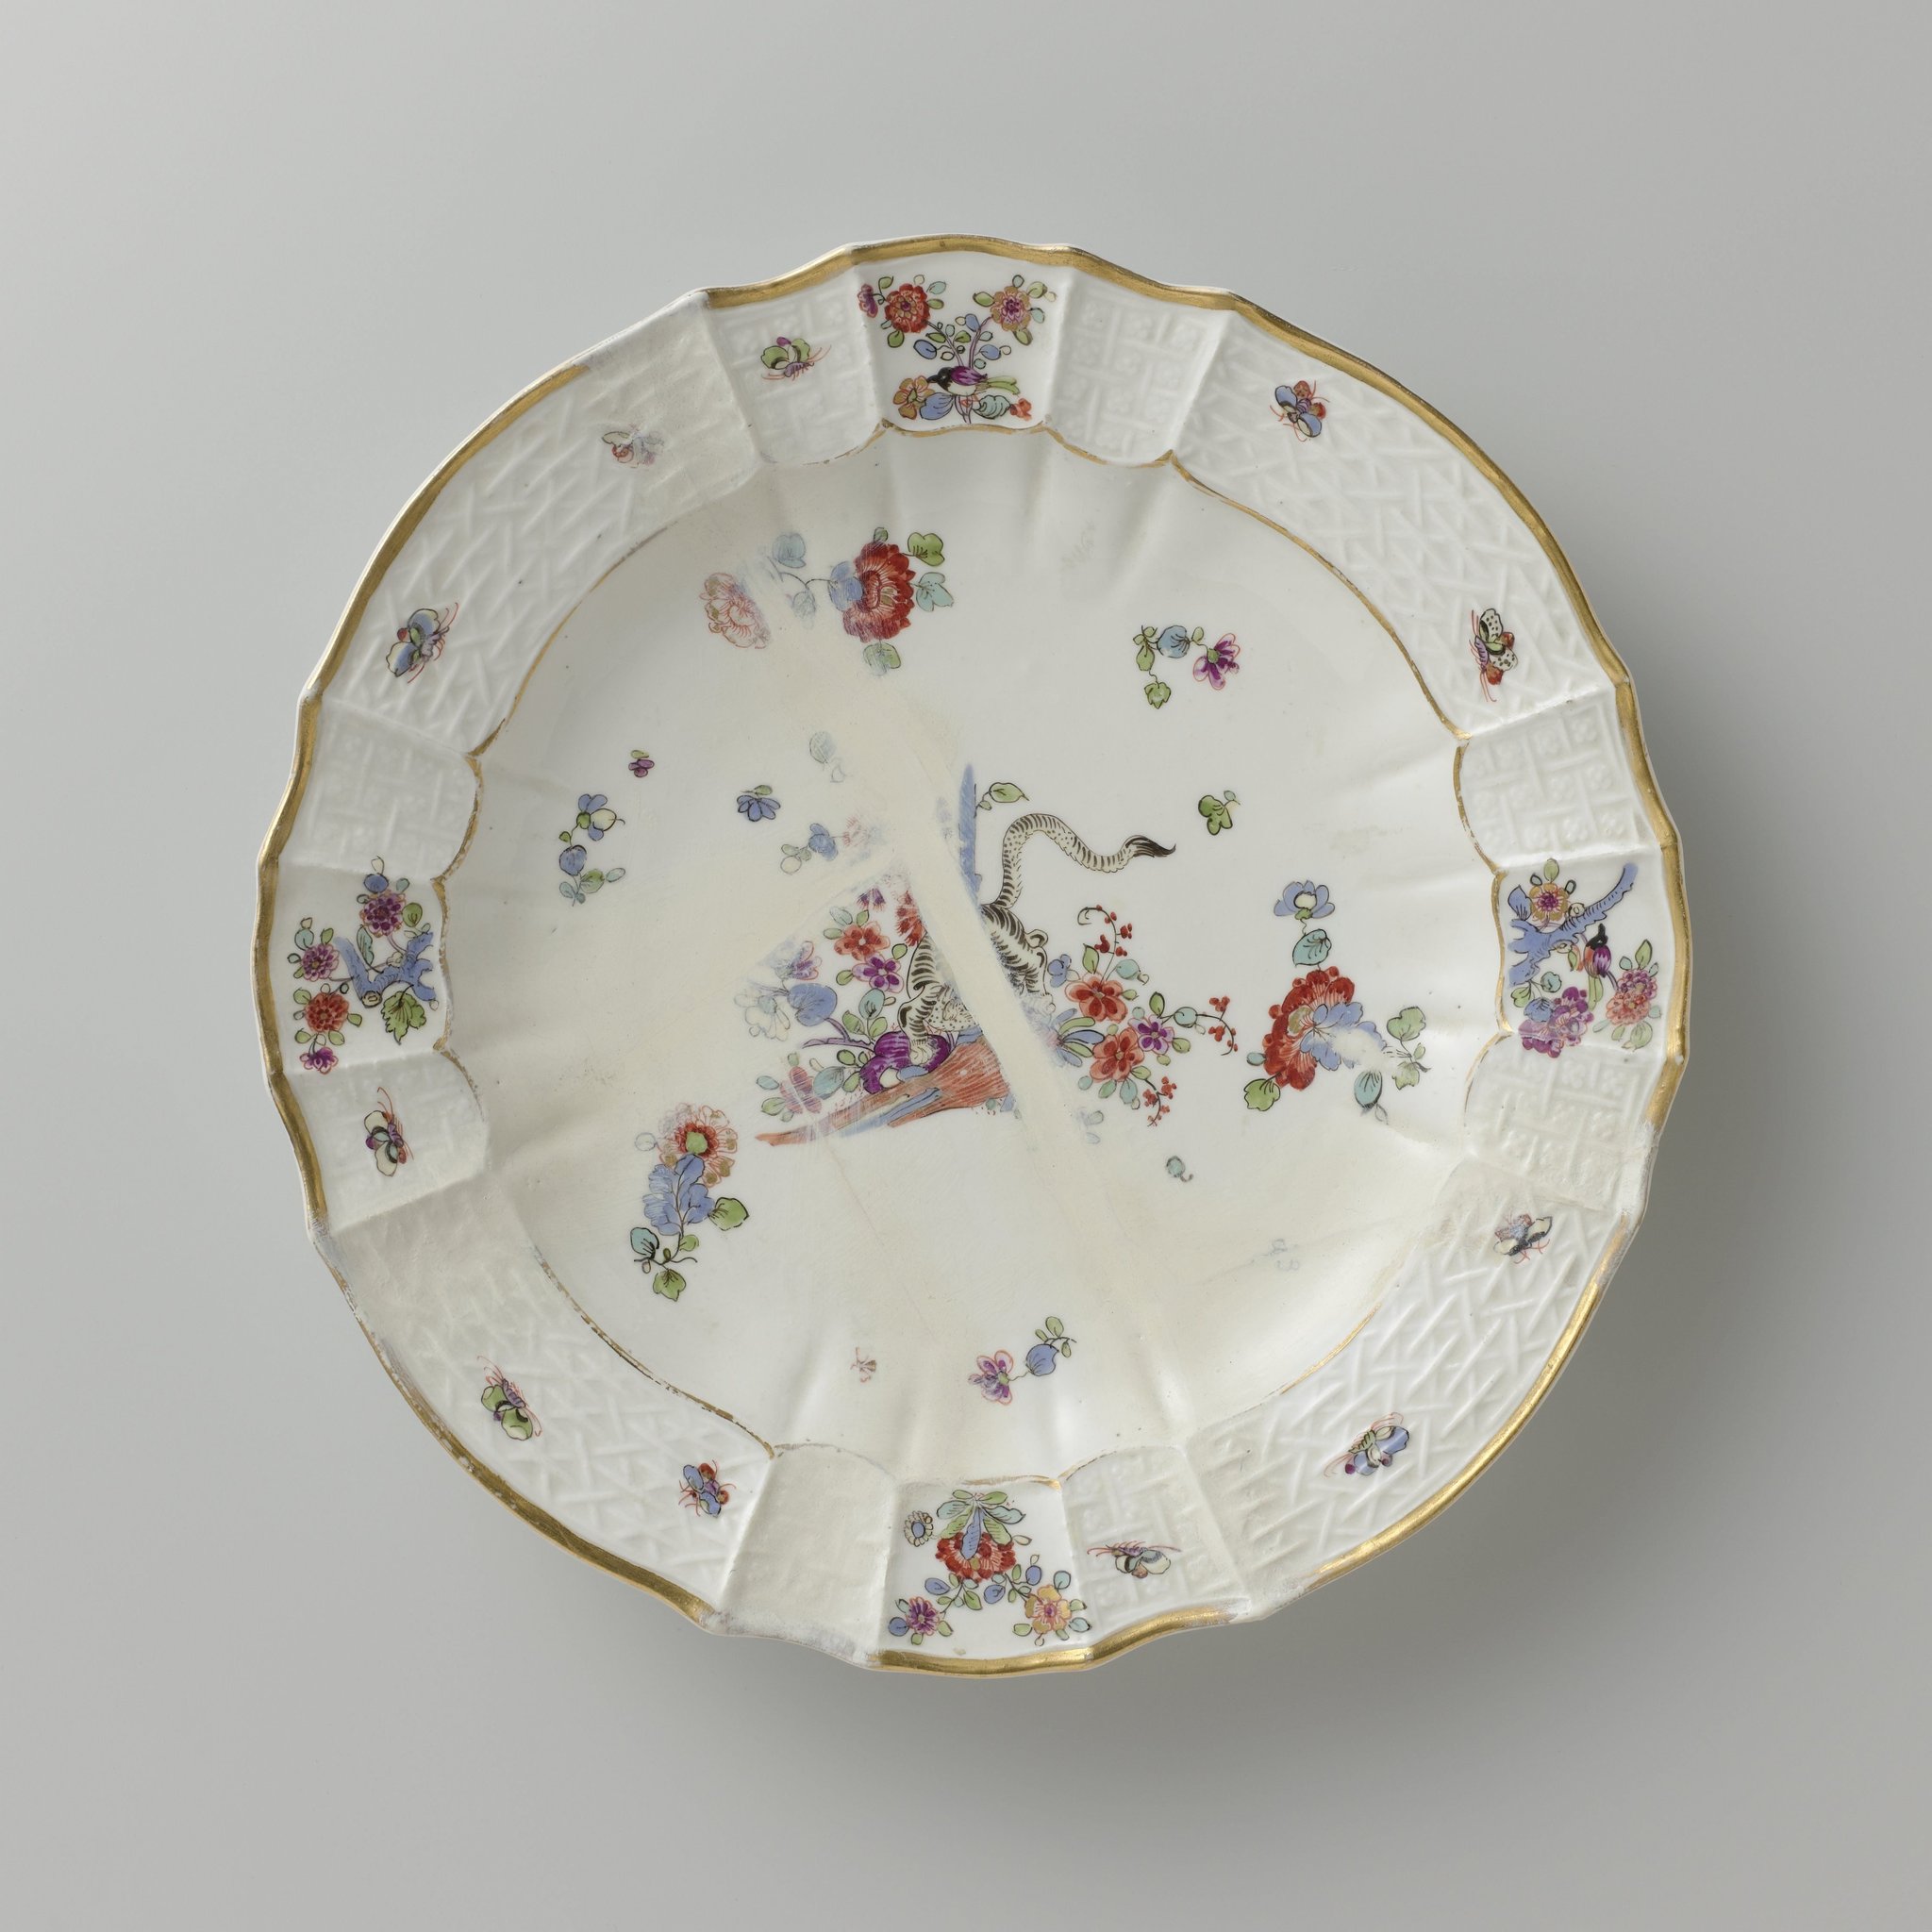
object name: plate dish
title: Rond bord, veelkleurig beschilderd met een Kakiemon-decor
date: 1740-1745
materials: porcelain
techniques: painted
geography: meissen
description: Rond bord van beschilderd porselein. Het bord is geribd en heeft een geschulpte rand. Het bord is beschilderd met een tijger die om een blauwe bamboestengel tussen bloemen is gedraaid, gestrooide Indianische Blumen, vlinders en takken waarop vogels. De rand is versierd met het 'Altbrandenstein'-patroon. Het bord is gemerkt.